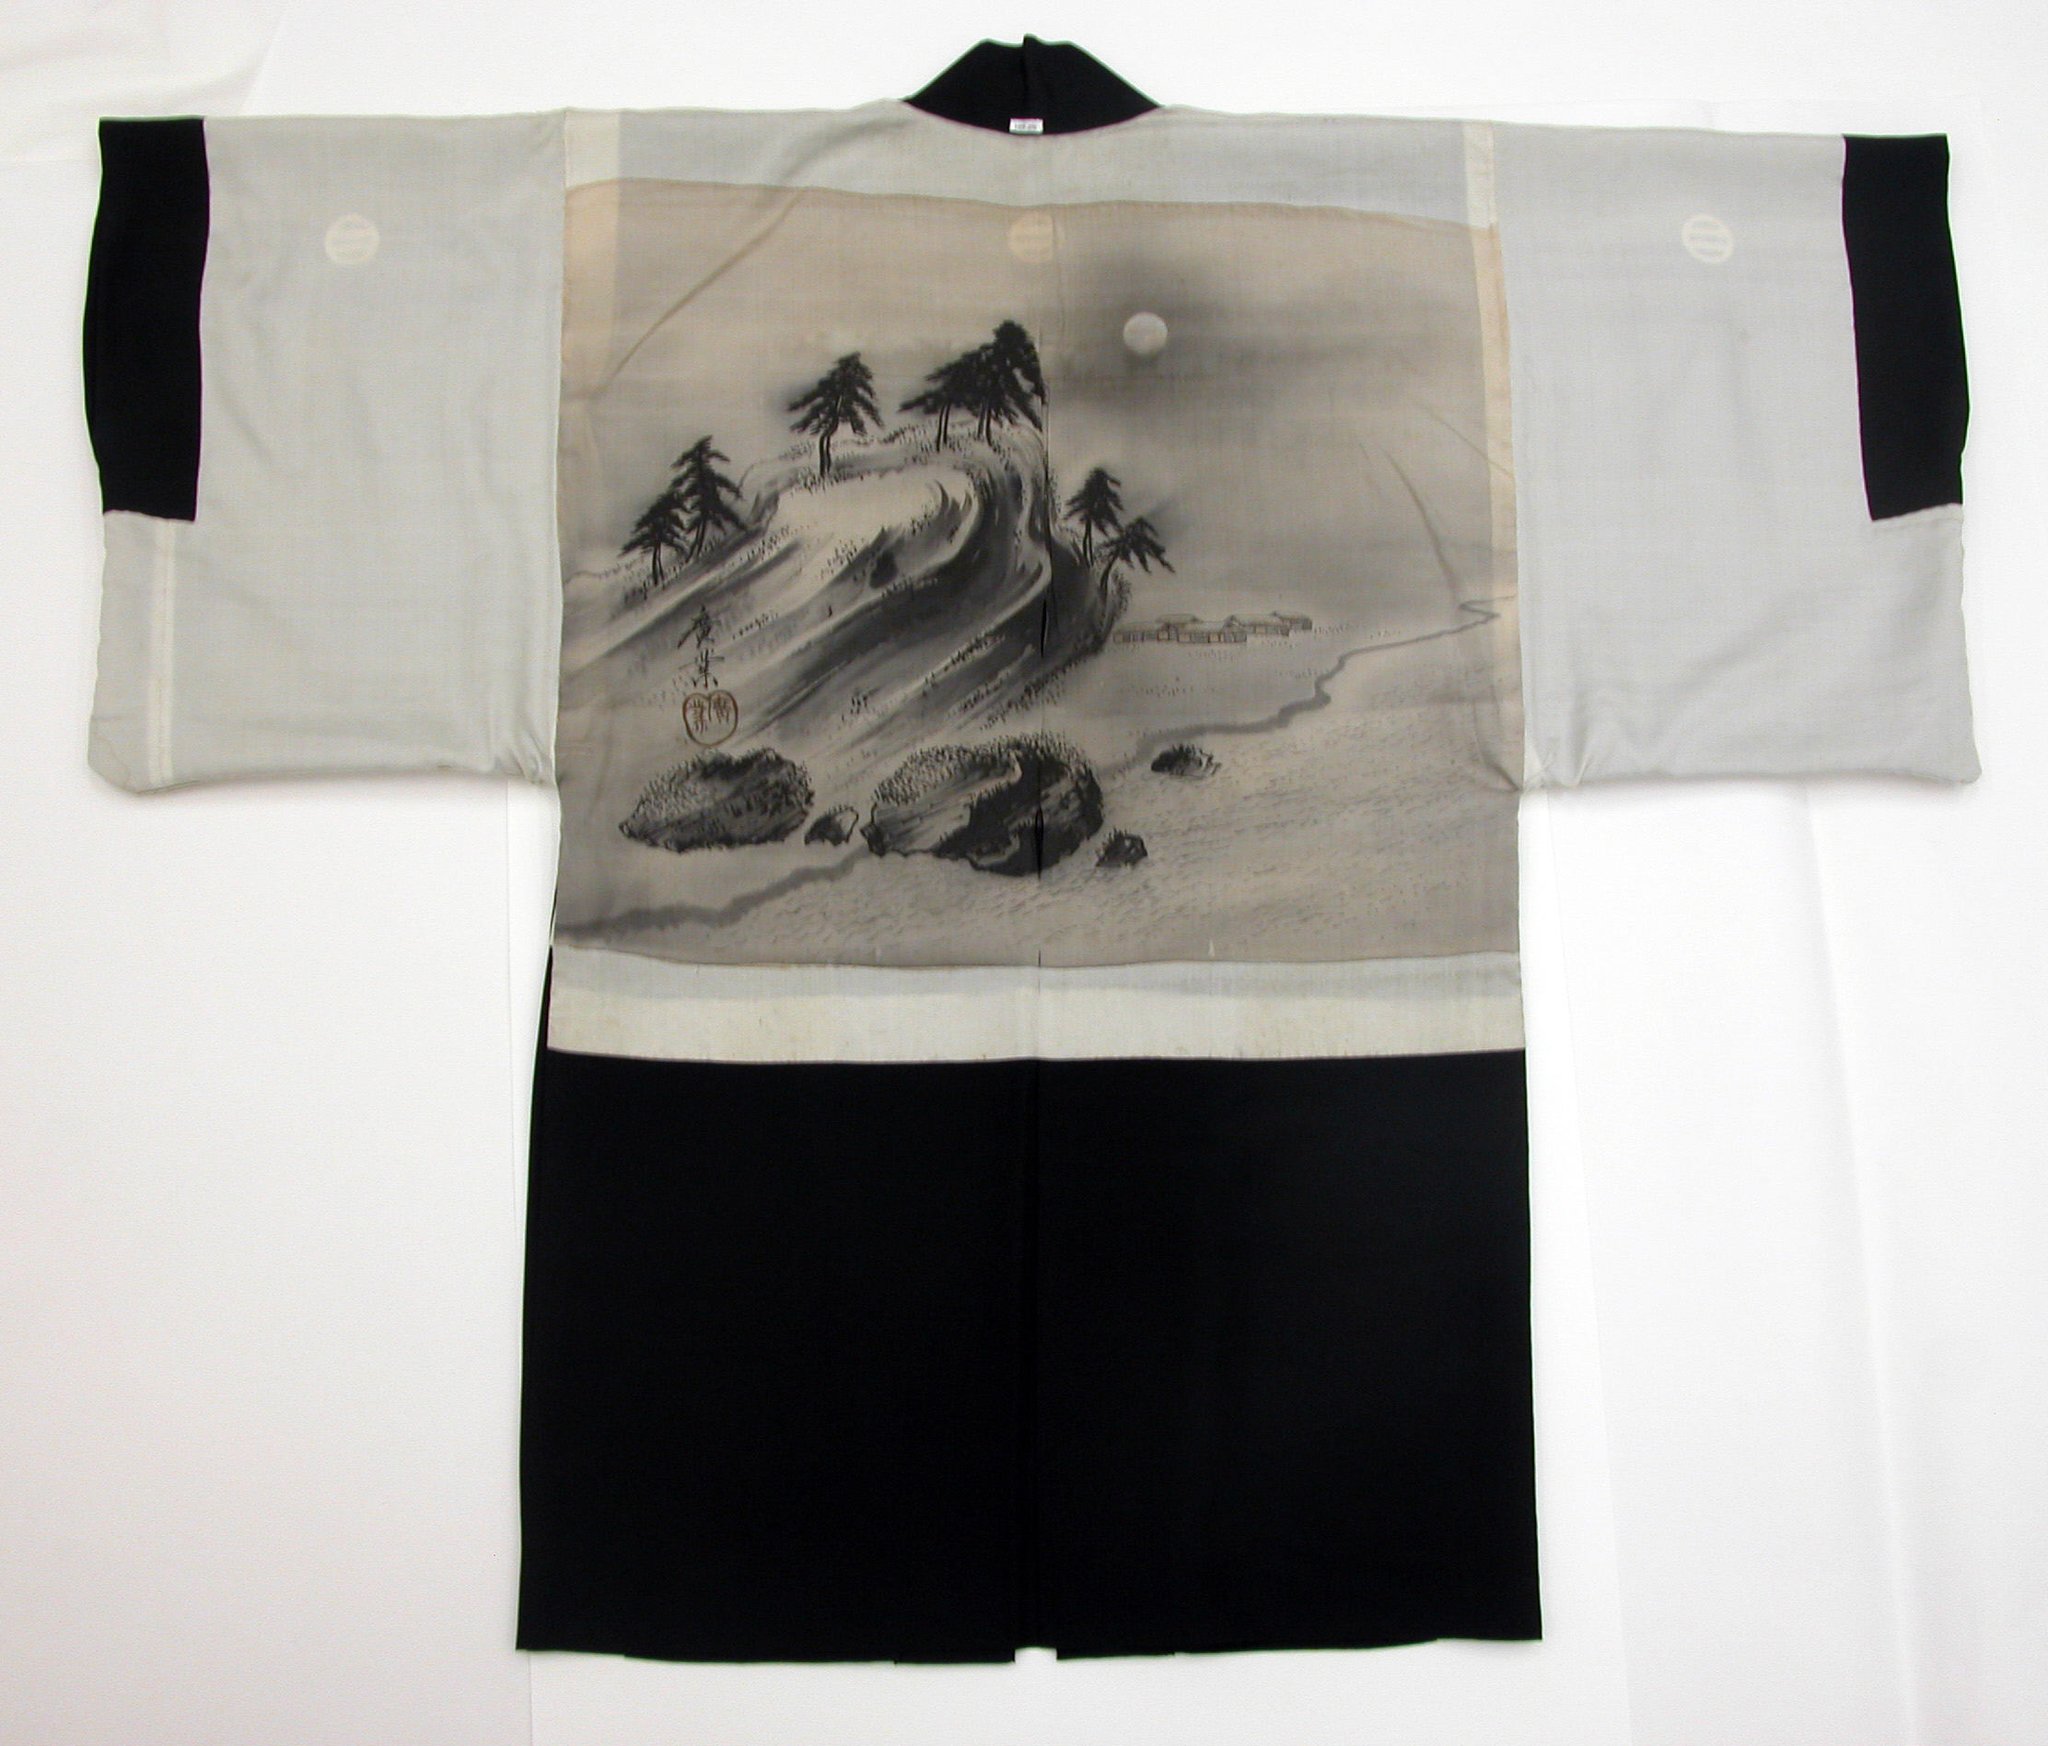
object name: man's jacket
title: Man's Jacket (Haori)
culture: japanese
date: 1801-1900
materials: silk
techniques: lining, painting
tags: moon,trees